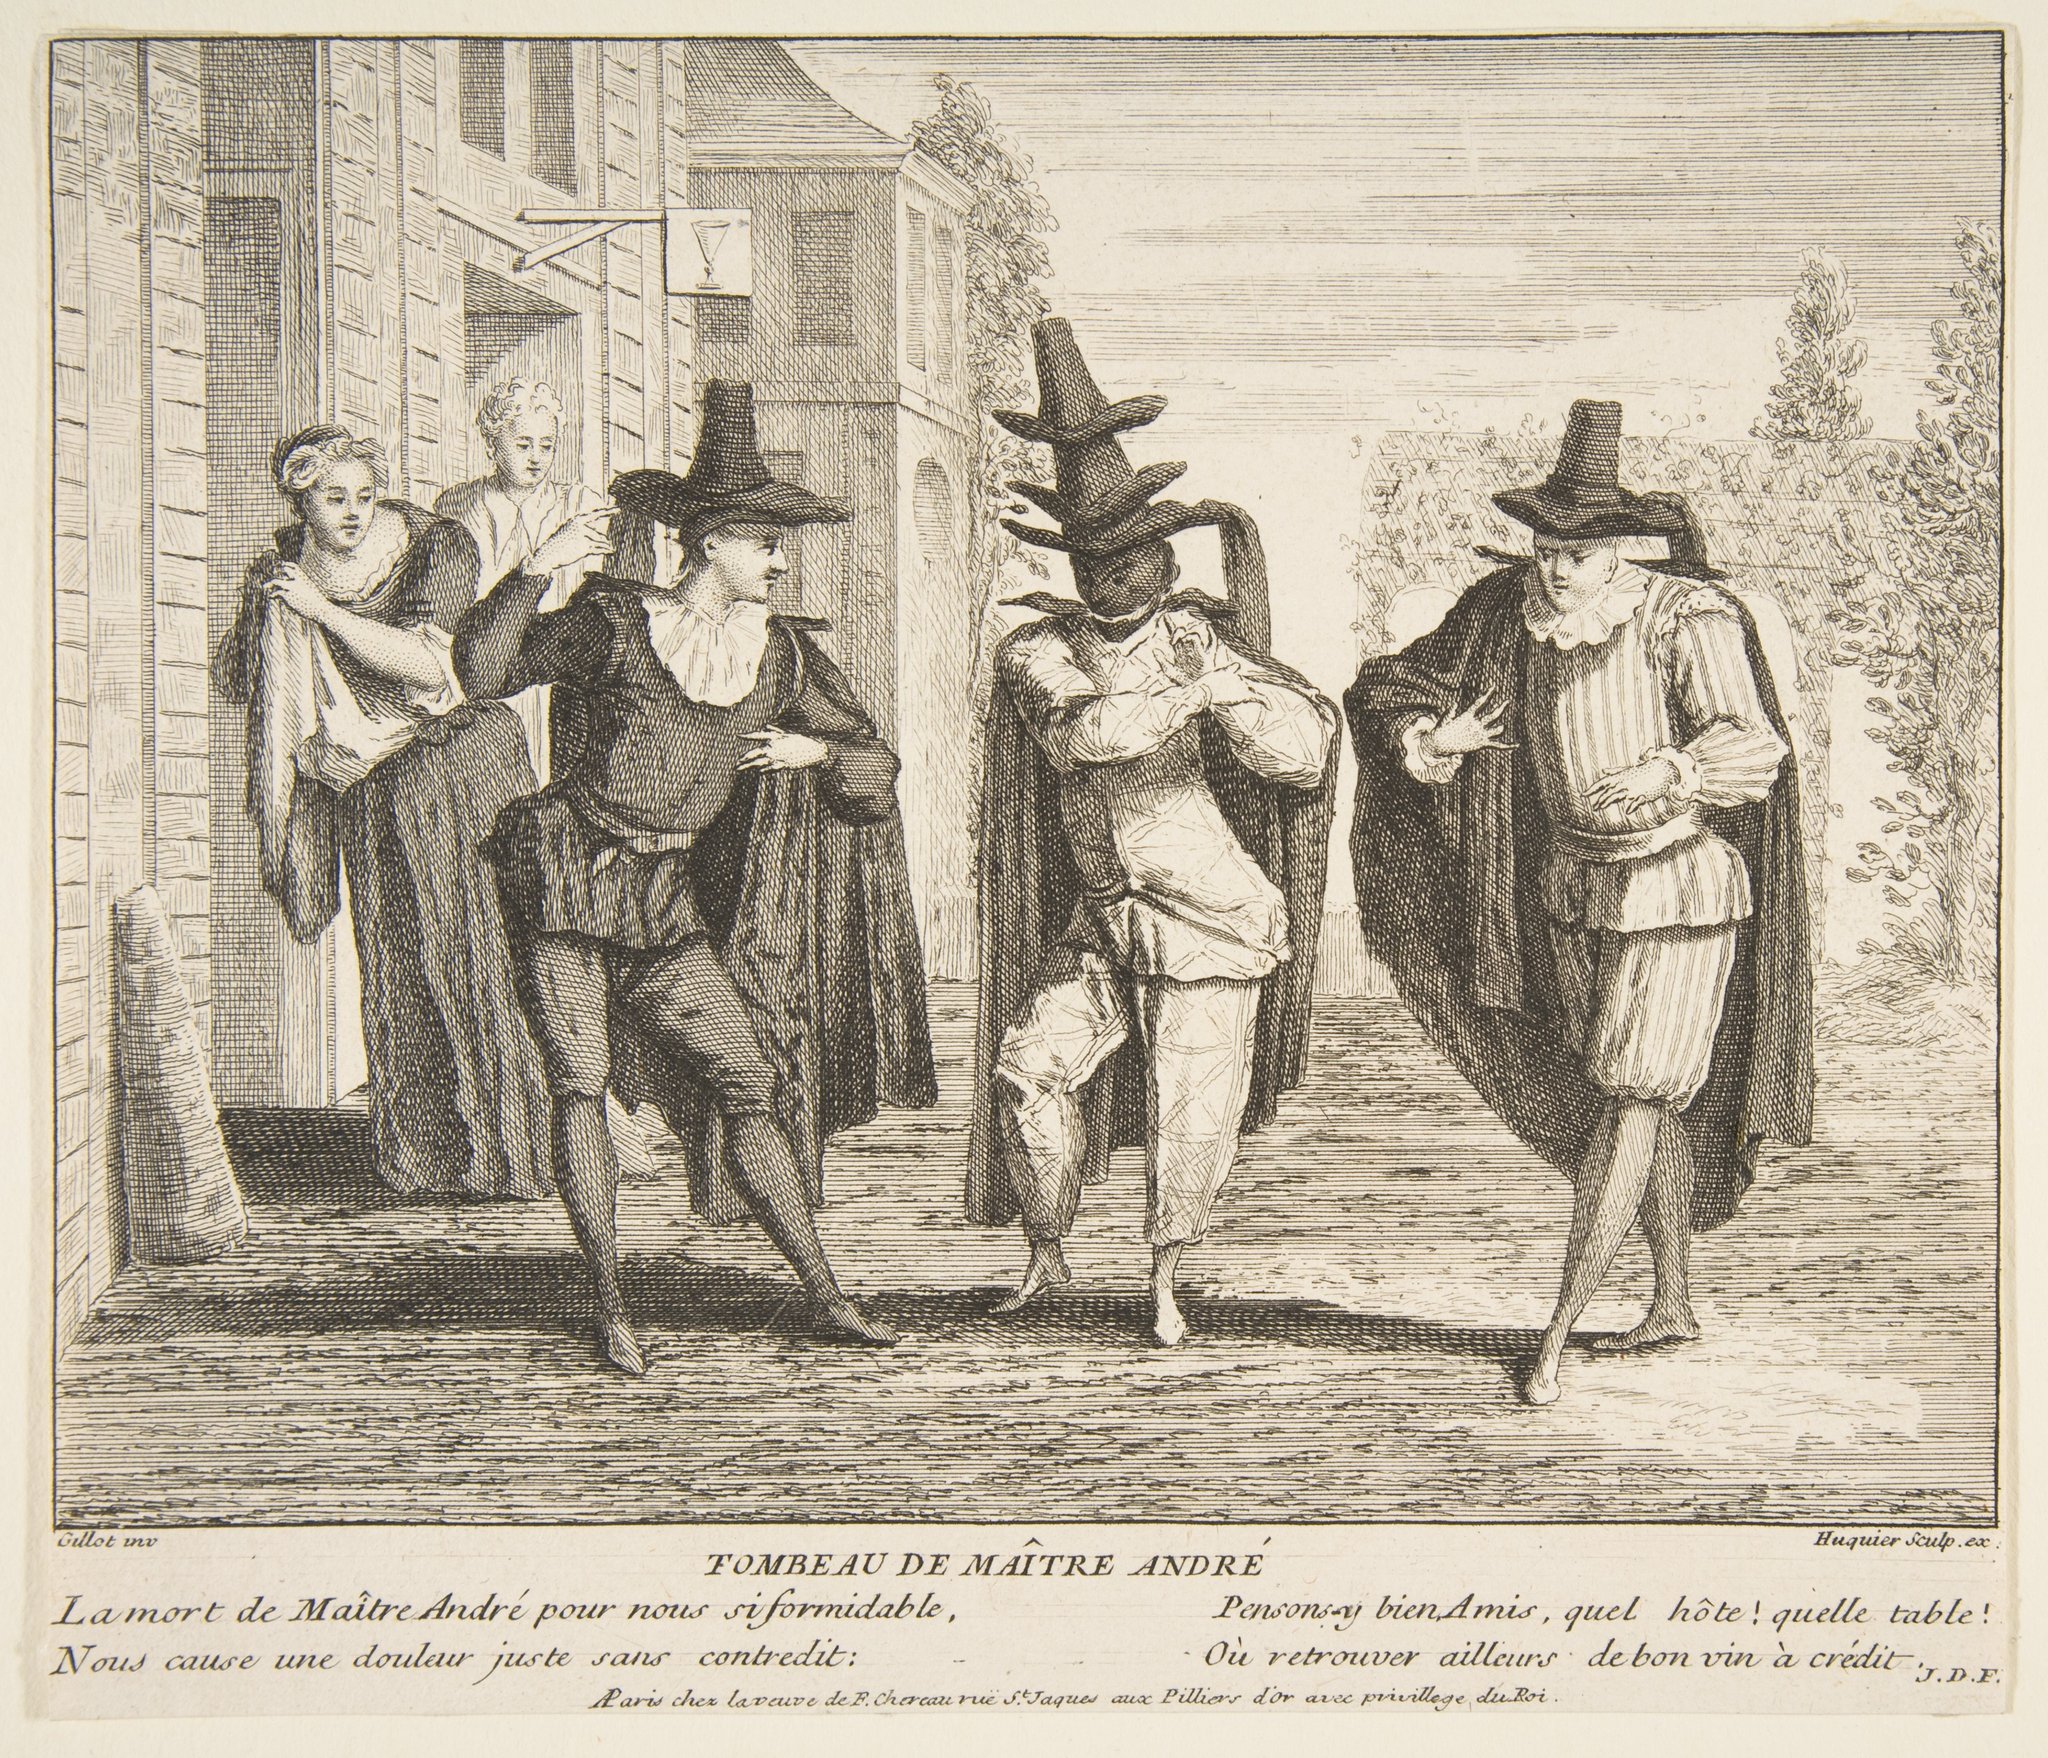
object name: print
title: The Death of Maitre Andre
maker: claude gillot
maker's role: artist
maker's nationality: french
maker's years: 1673-1722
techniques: etching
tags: buildings,men,women